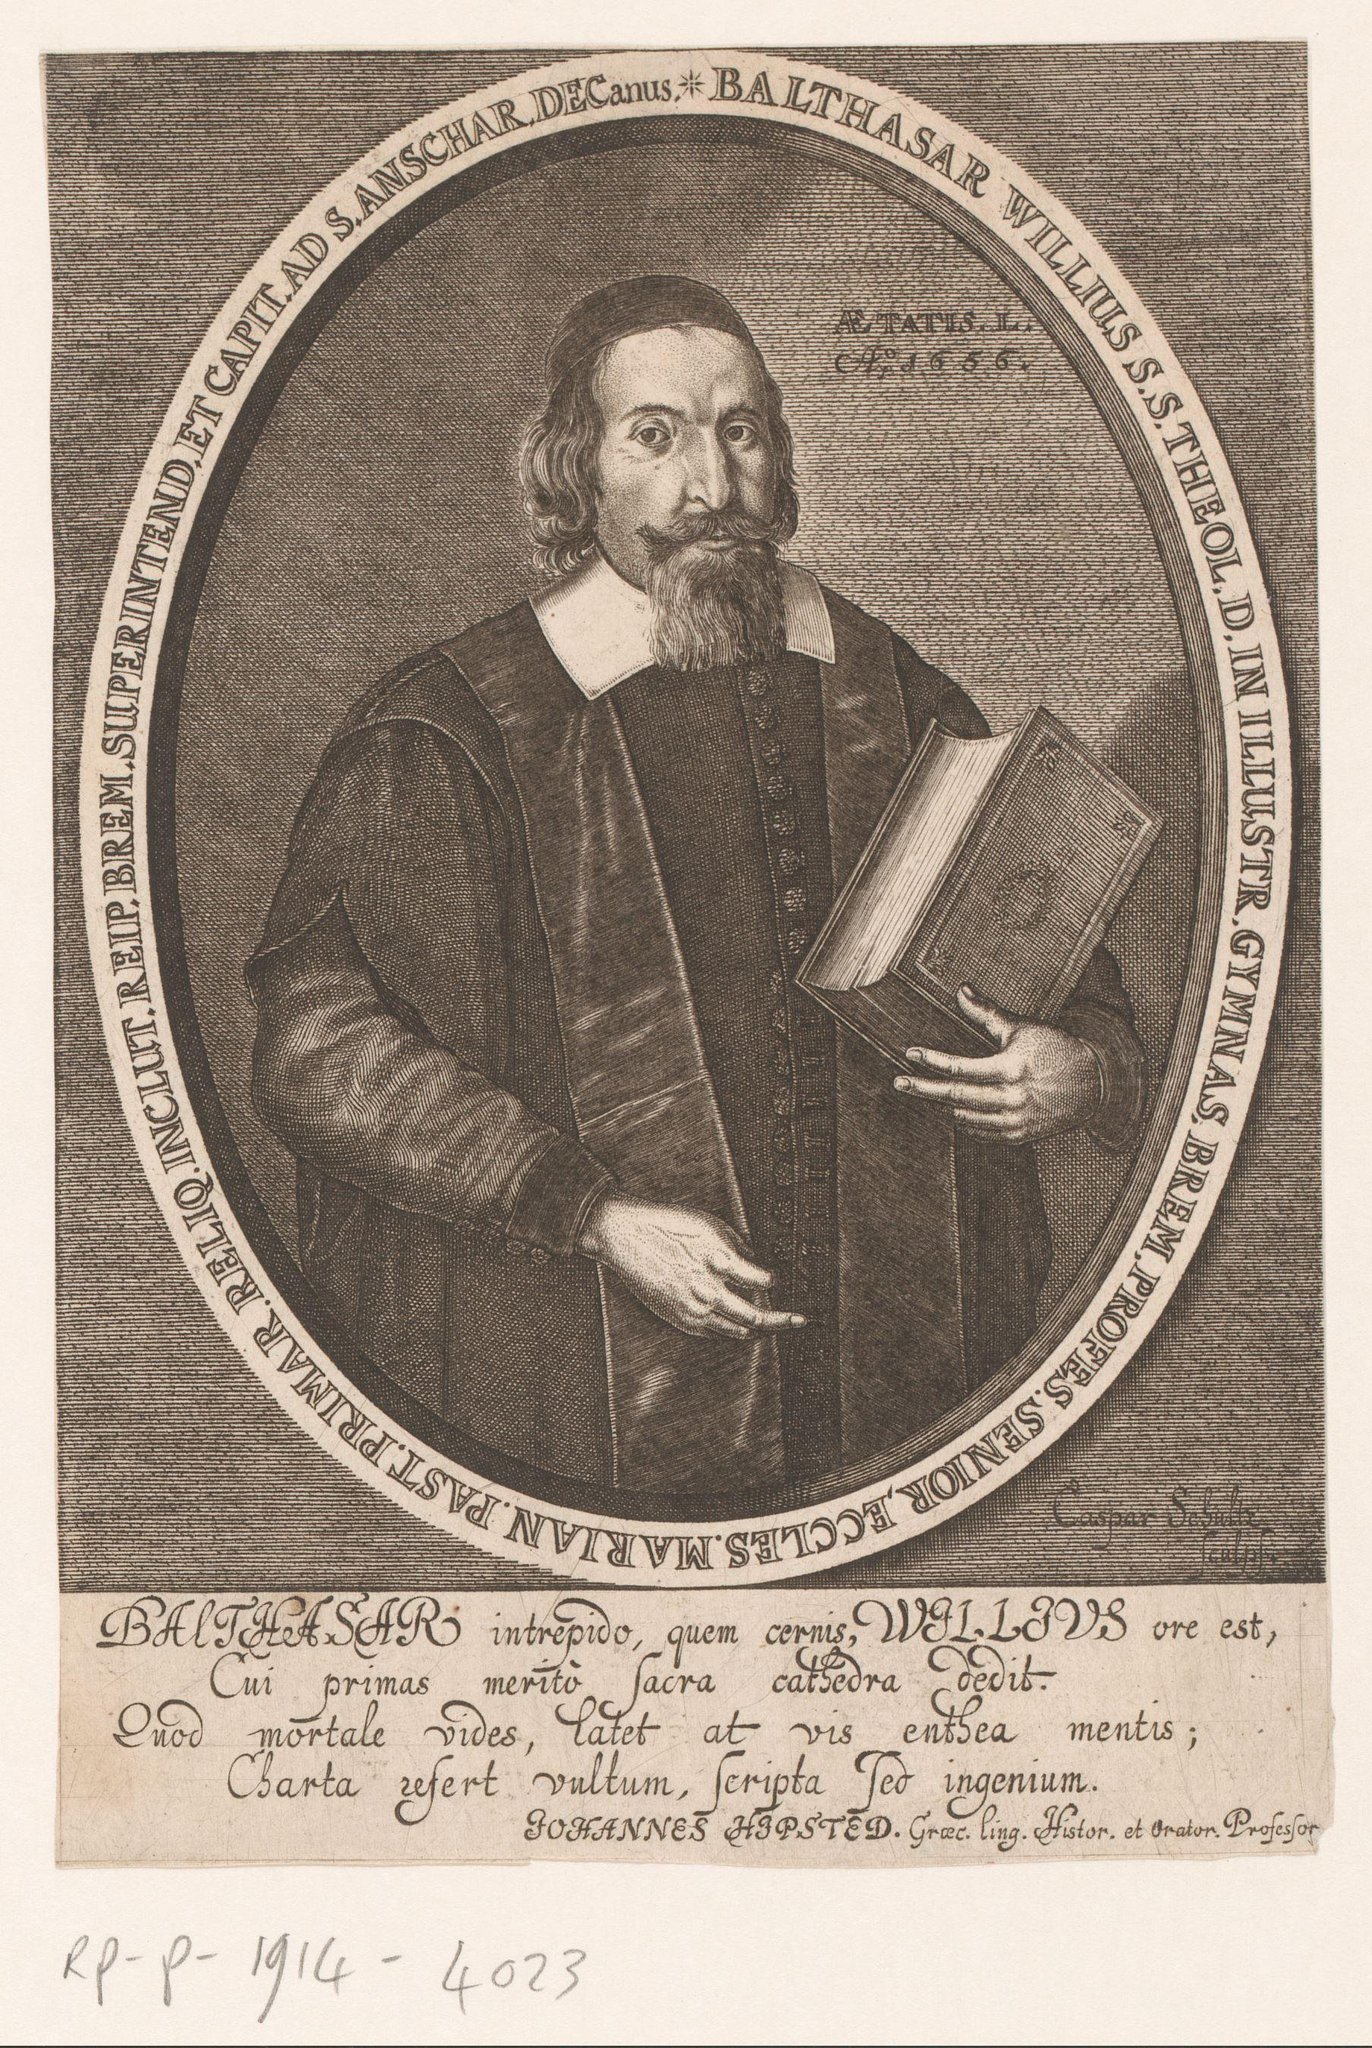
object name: print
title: Portret van Balthasar Wille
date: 1656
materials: paper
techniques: engraving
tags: balthasar wille, historical persons, portrait of a writer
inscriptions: collector's mark: Lugt 2228